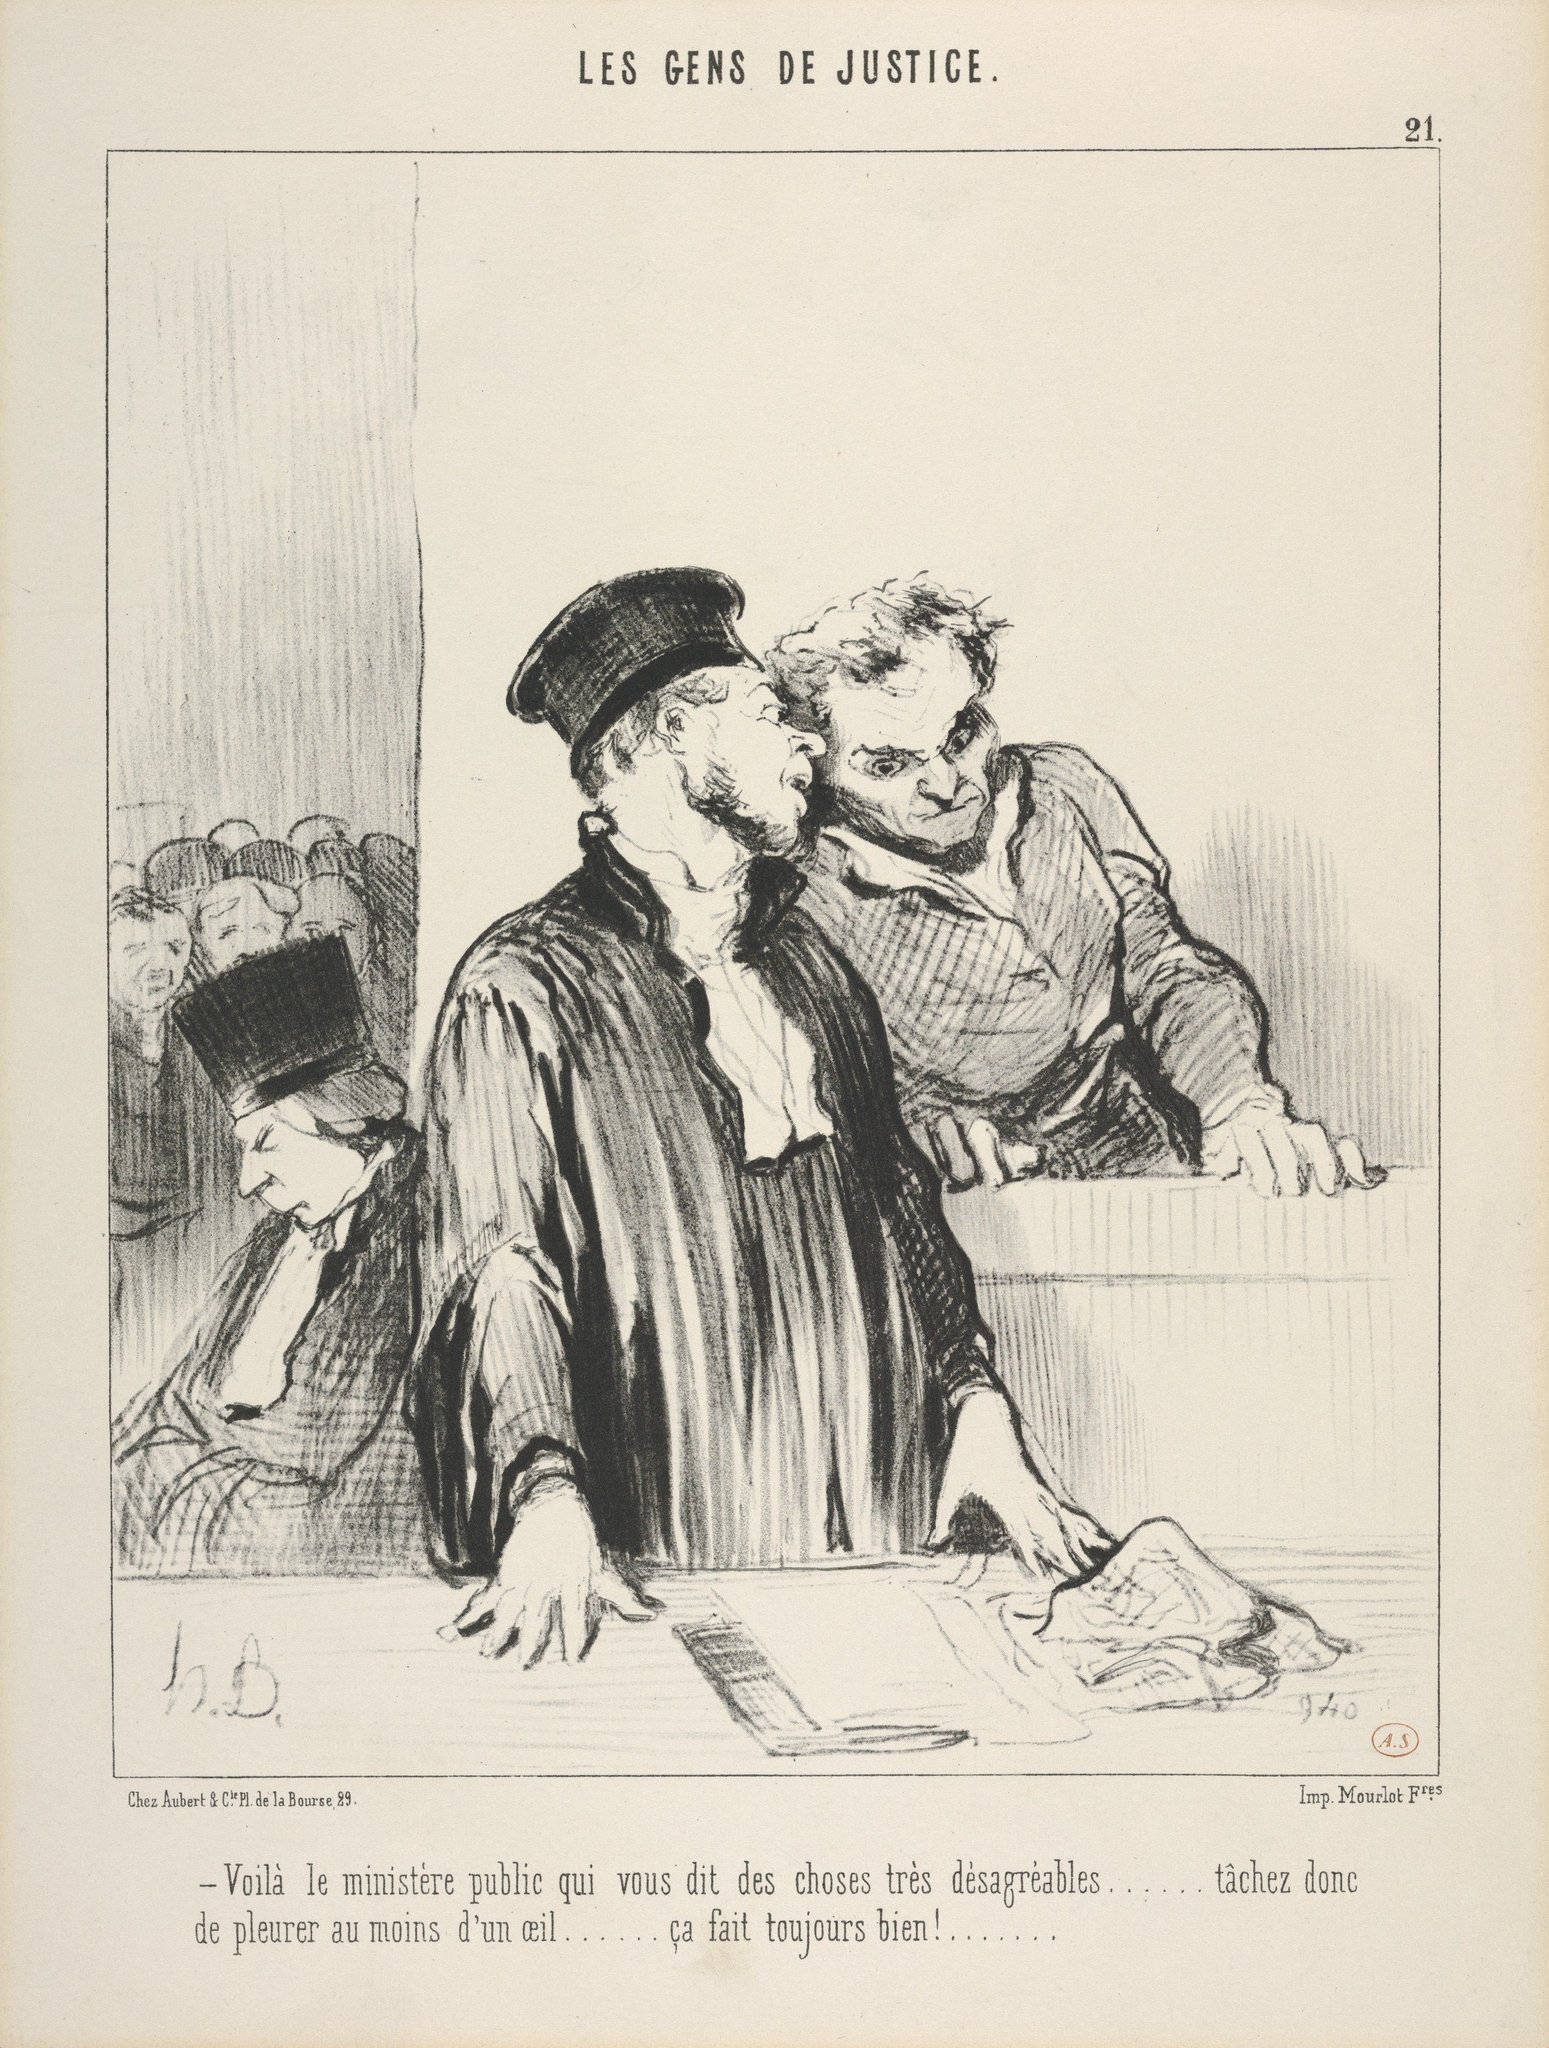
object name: print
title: Le Gens de Justice, Plate 21, "Voila le ministere public qui vous dit des choses tres desagreeables"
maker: honoré daumier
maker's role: artist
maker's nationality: french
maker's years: 1808-1879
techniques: lithograph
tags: men,law